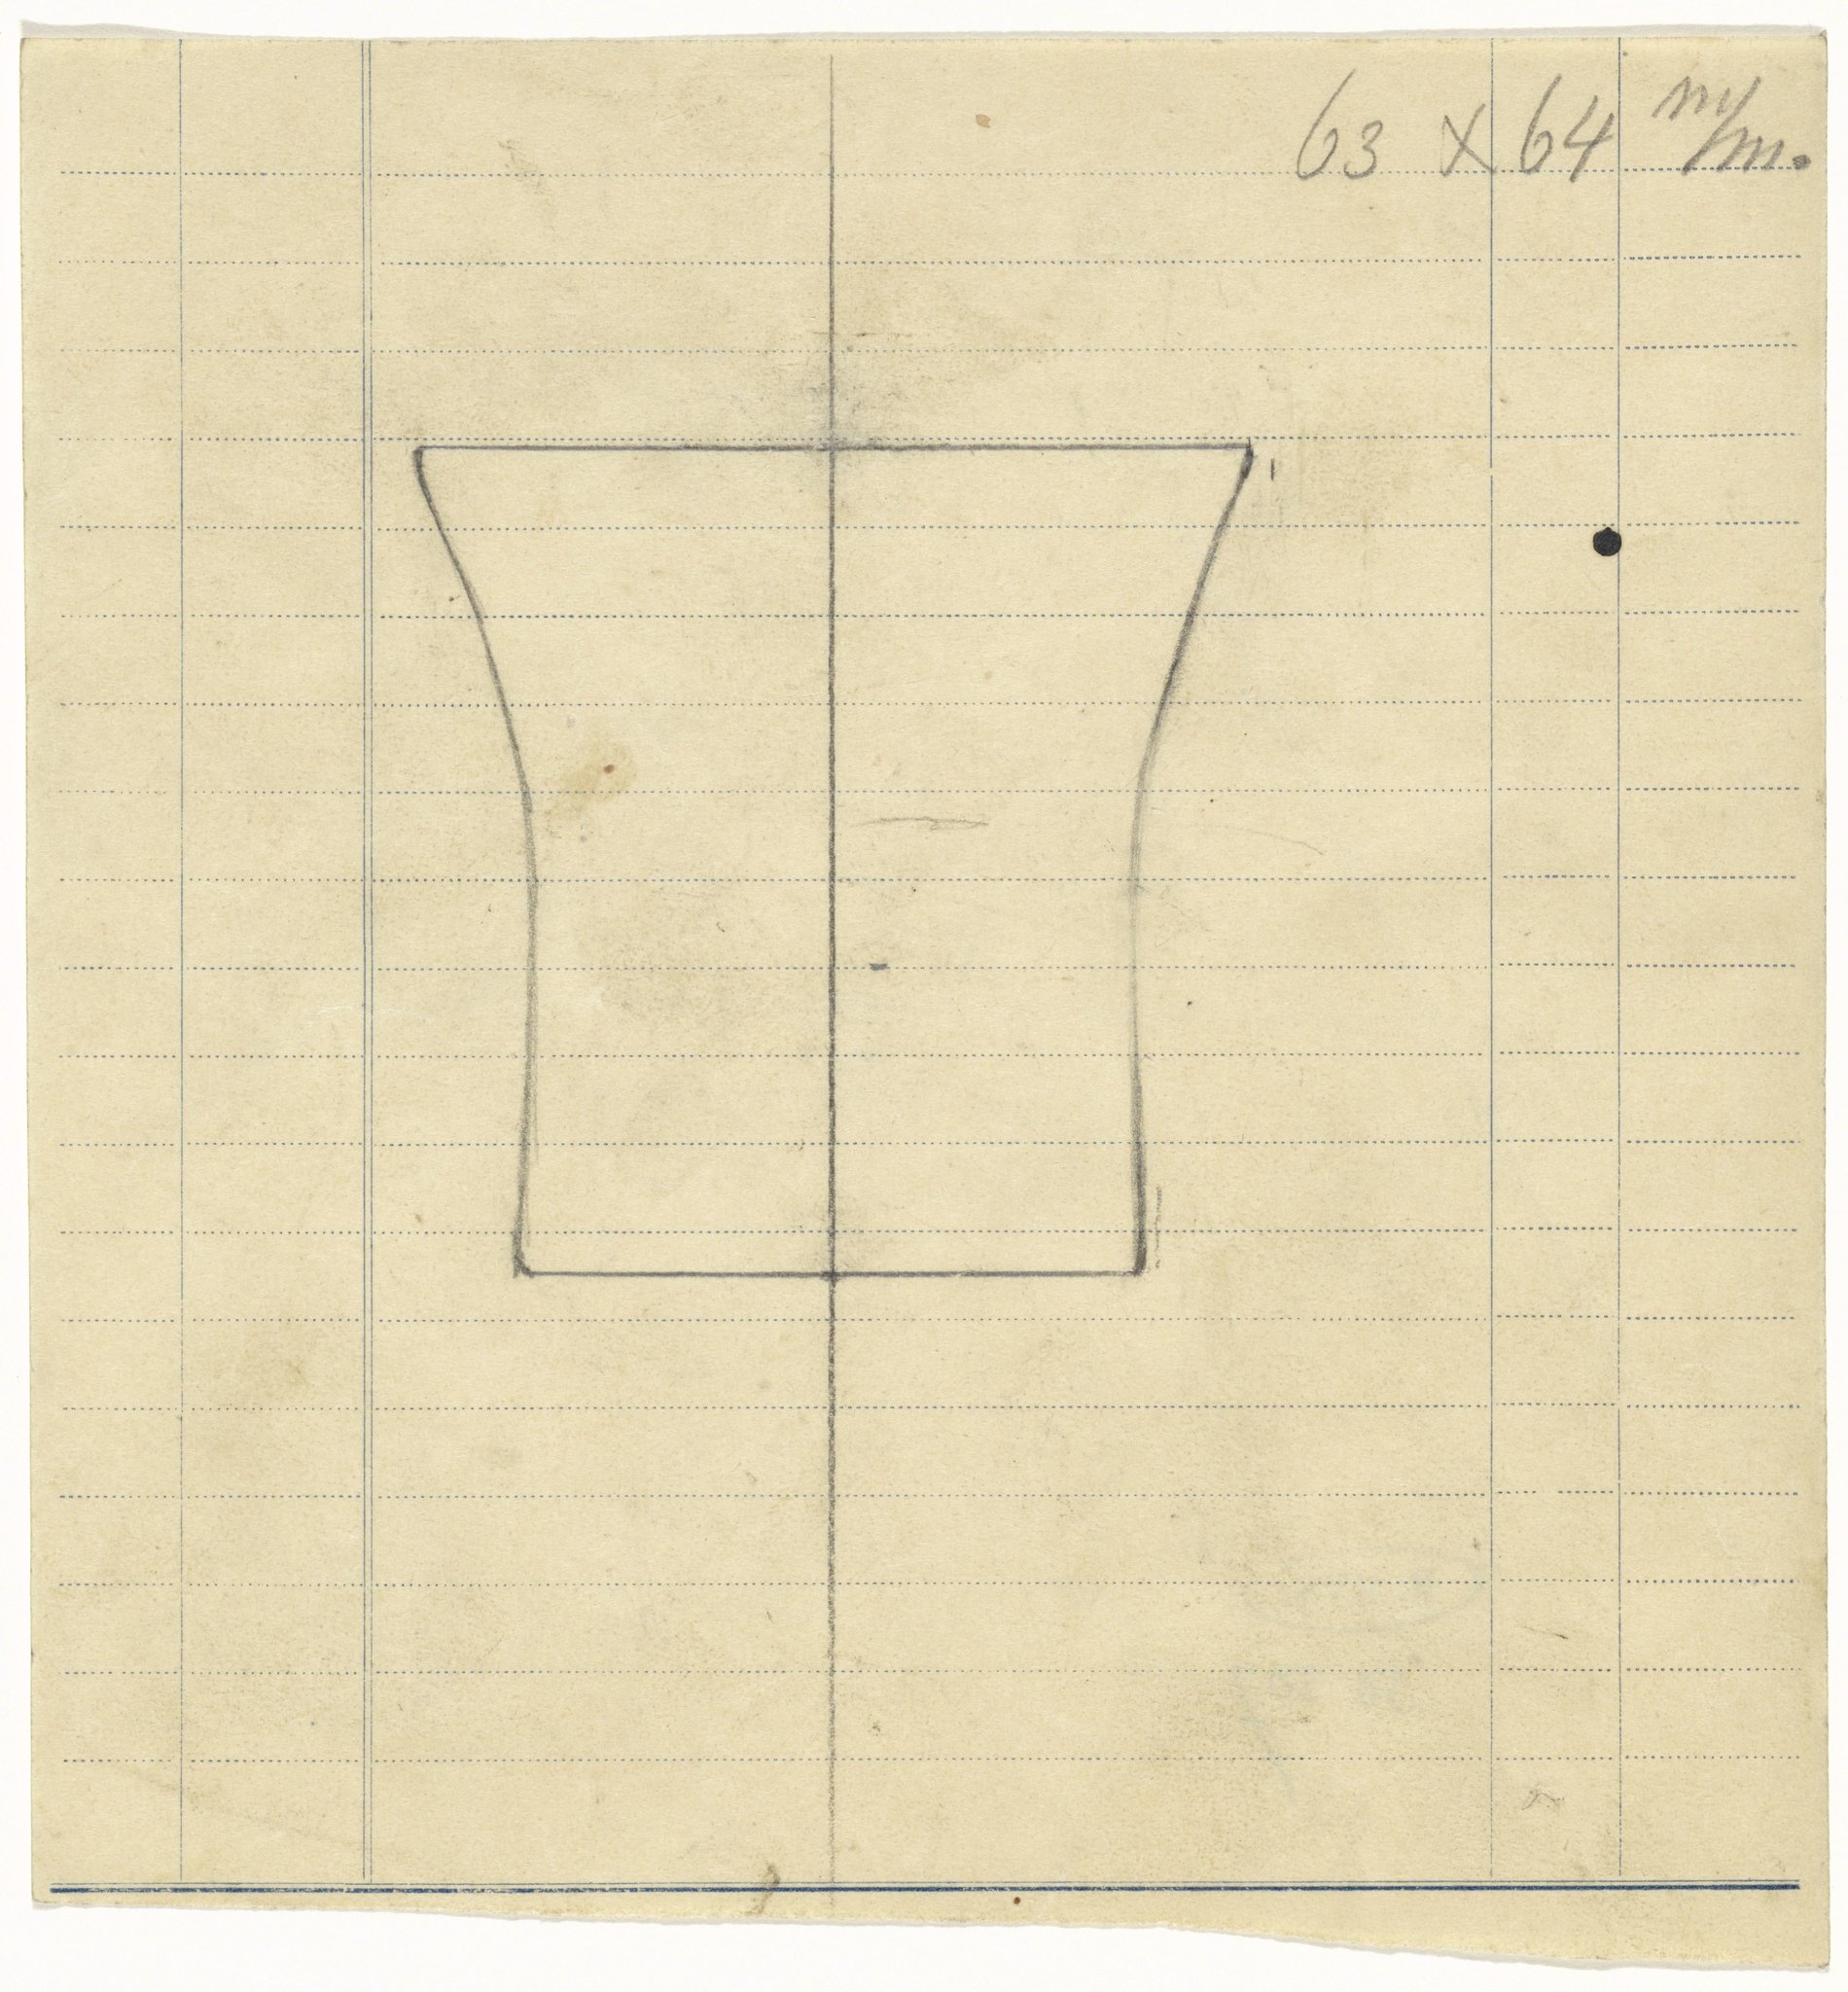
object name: design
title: Ontwerp voor een doopbeker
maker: mathieu lauweriks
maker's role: designer, draughtsman, print maker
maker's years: 1864-1932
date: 1874-1932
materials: paper, pencil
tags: other utensils used in the church (baptismal cup)